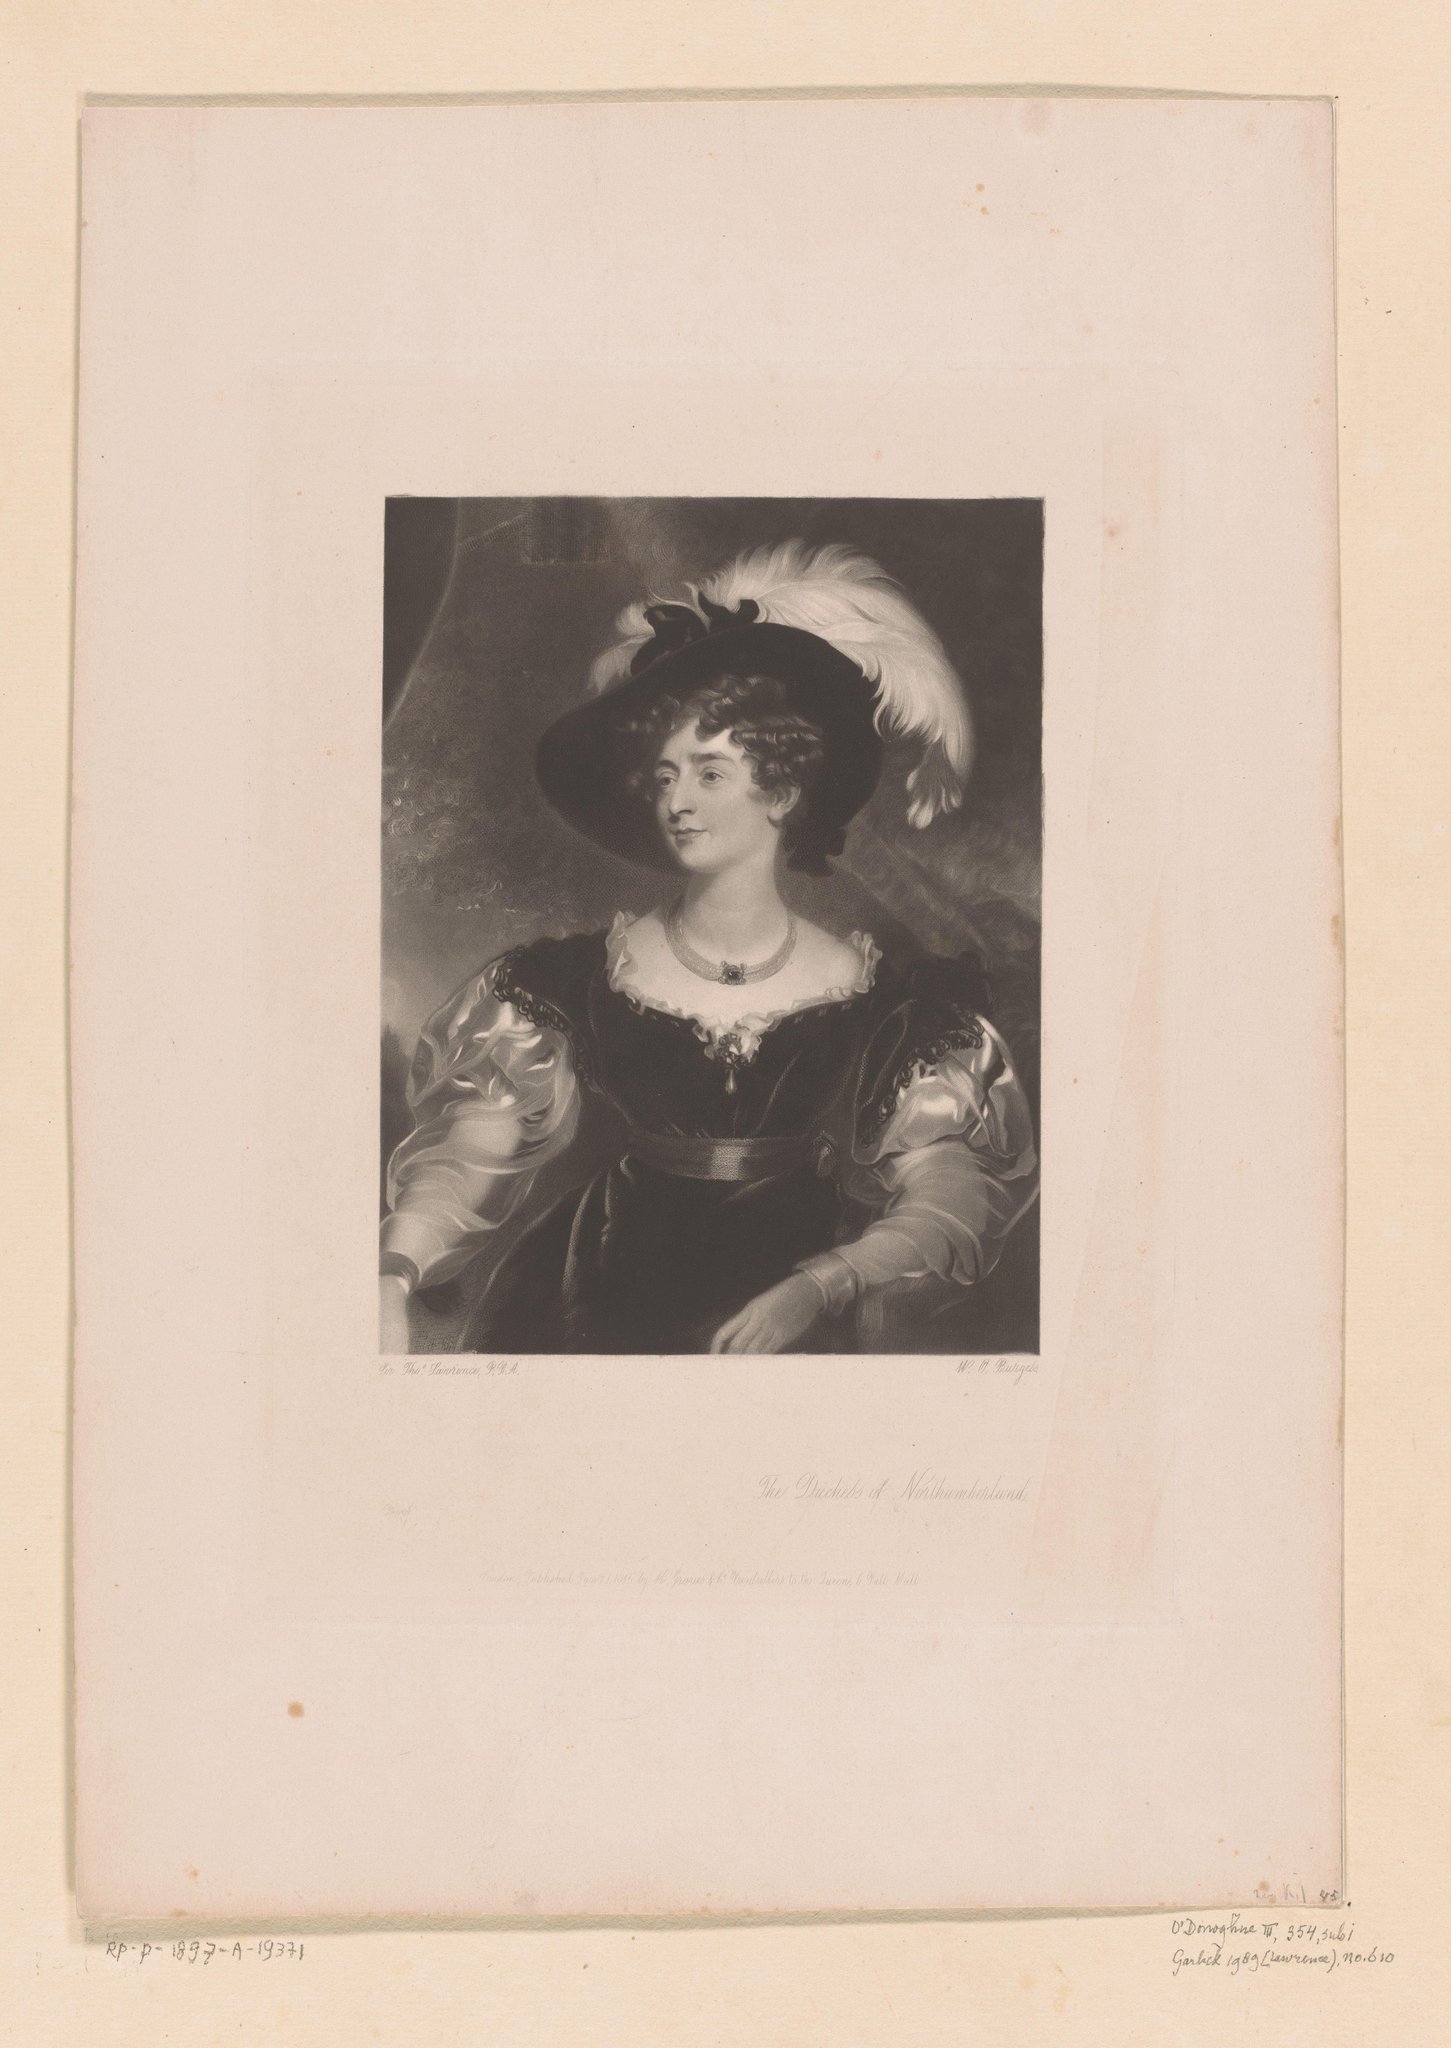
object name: print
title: Portret van Charlotte Percy, hertogin van Northumberland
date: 1845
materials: paper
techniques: mezzotint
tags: historical persons